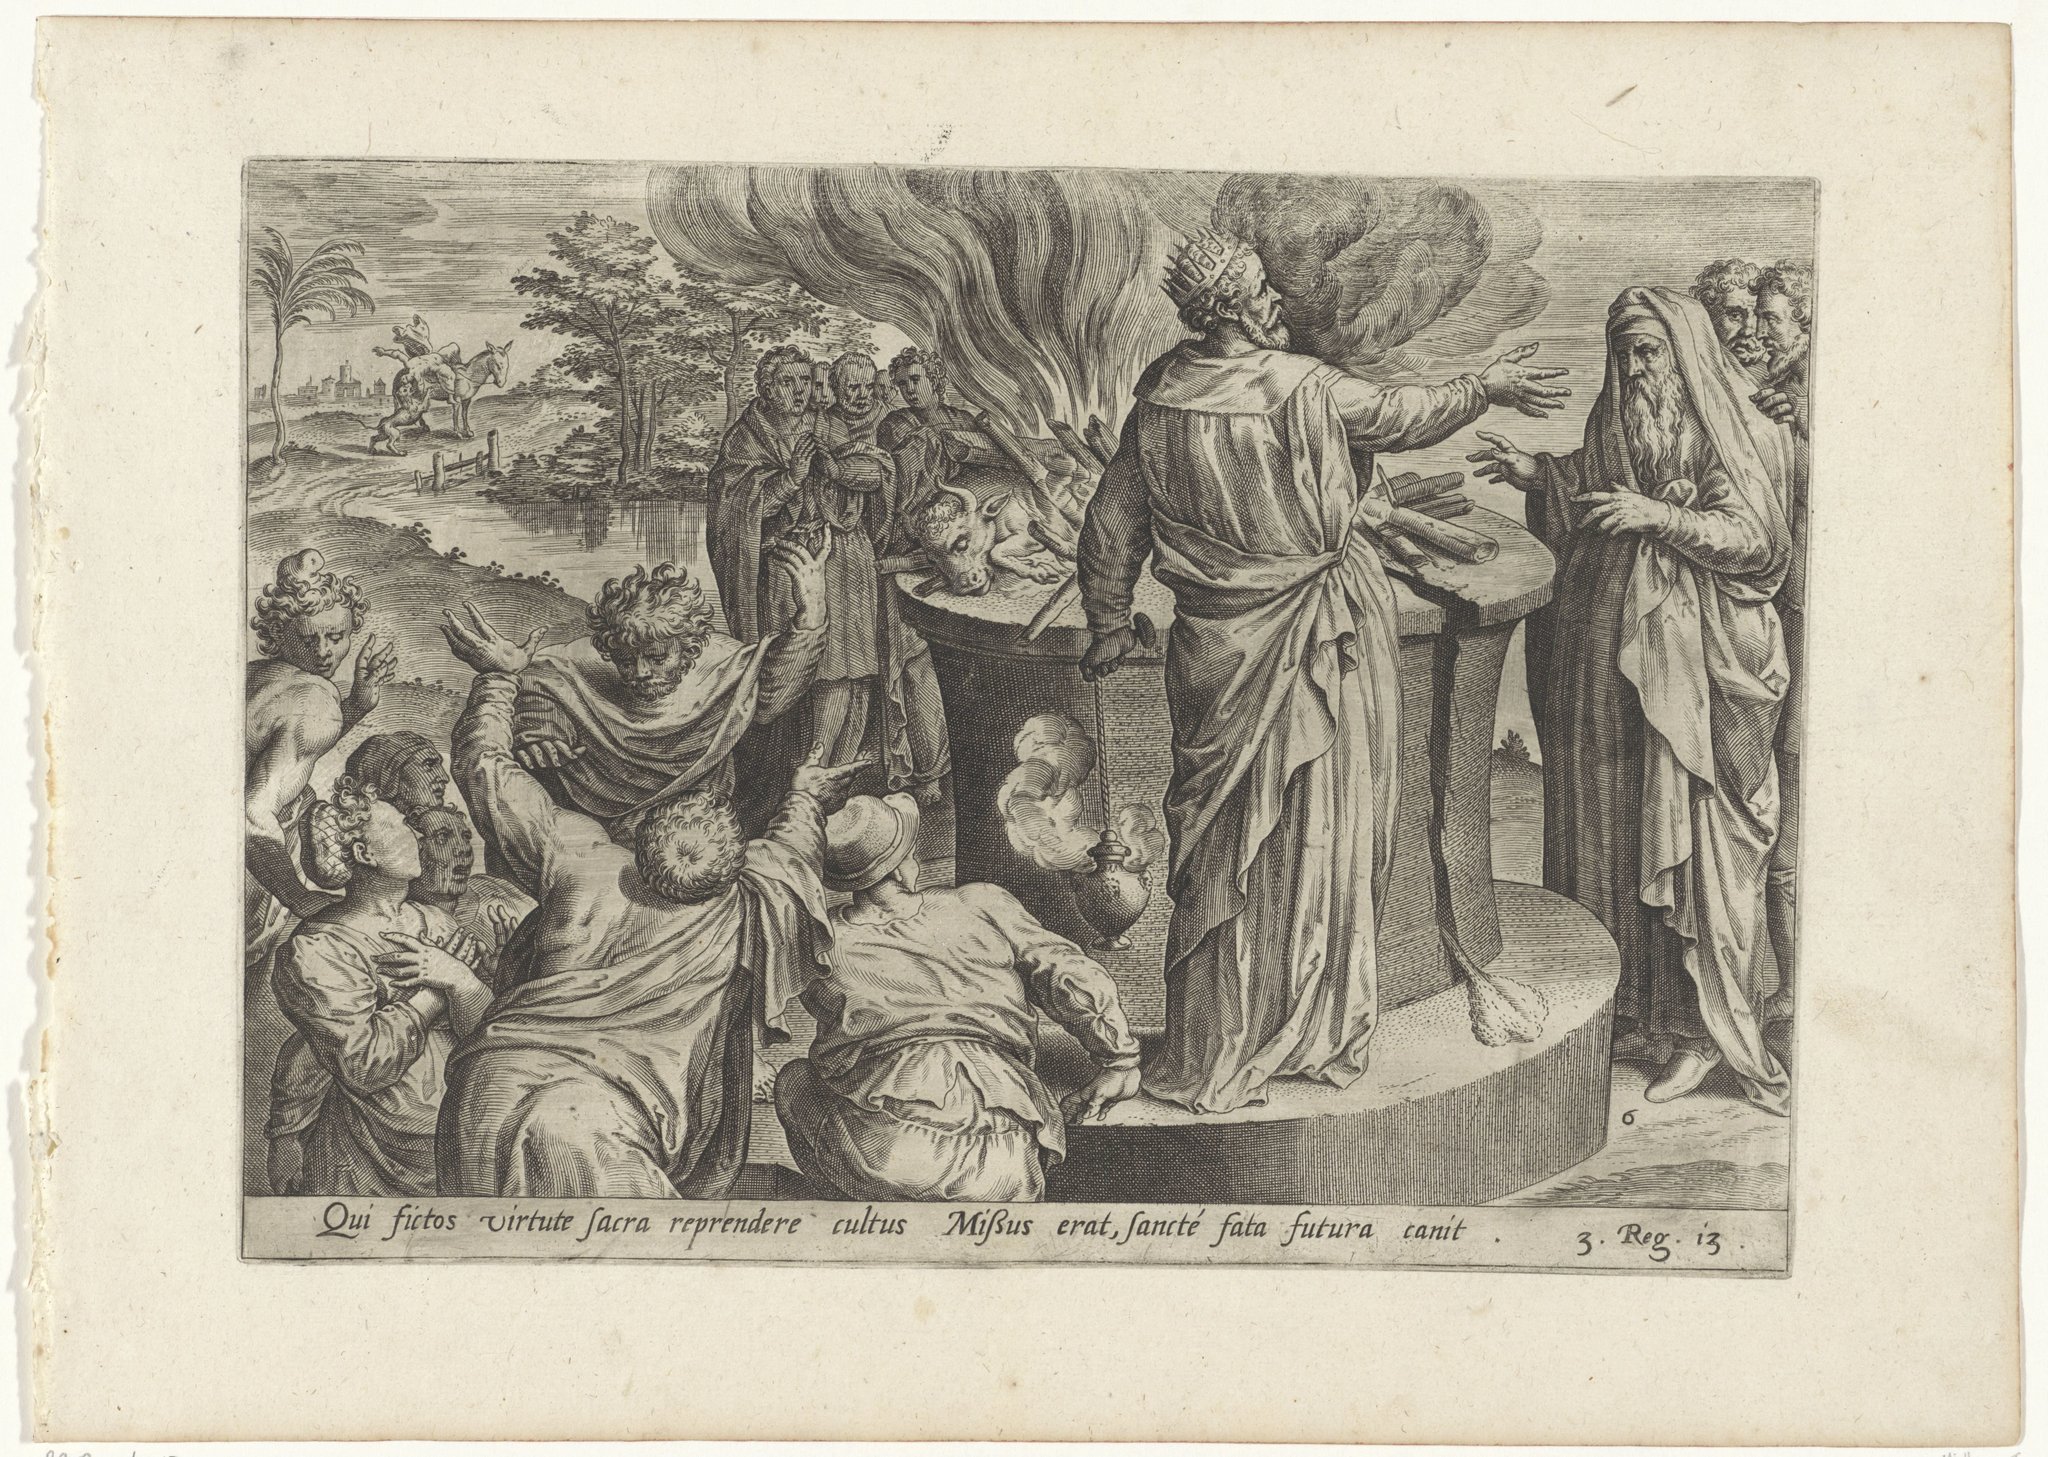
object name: print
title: Thesaurus sacrarum historiarum veteris testamenti (...)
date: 1579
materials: paper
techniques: engraving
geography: antwerp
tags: 'a man of god' from judah comes to bethel and prophesies to jeroboam the destruction of the altar, as king jeroboam points to the prophet and orders his seizure, his hand withers and the altar falls apart, the prophet of judah rides off with his donkey and on his way is killed by a lion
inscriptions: collector's mark: Lugt 2228, collector's mark: Lugt 2760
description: Koning Jerobeam brengt een offer aan een afgod als een godsman uit Juda verschijnt. De godsman profeteert en kondigt het wonder aan dat het altaar zal splijten en de as op de grond zal vallen. De uitgestrekte arm van Jerobeam verstijft als hij de opdracht geeft de godsman gevangen te nemen. Links op de achtergrond is het einde van de godsman verbeeld. De godsman wordt gedood door een leeuw en van zijn ezel getrokken. Onder de voorstelling een verwijzing in het Latijn naar de Bijbeltekst in 1 Kon. 13.